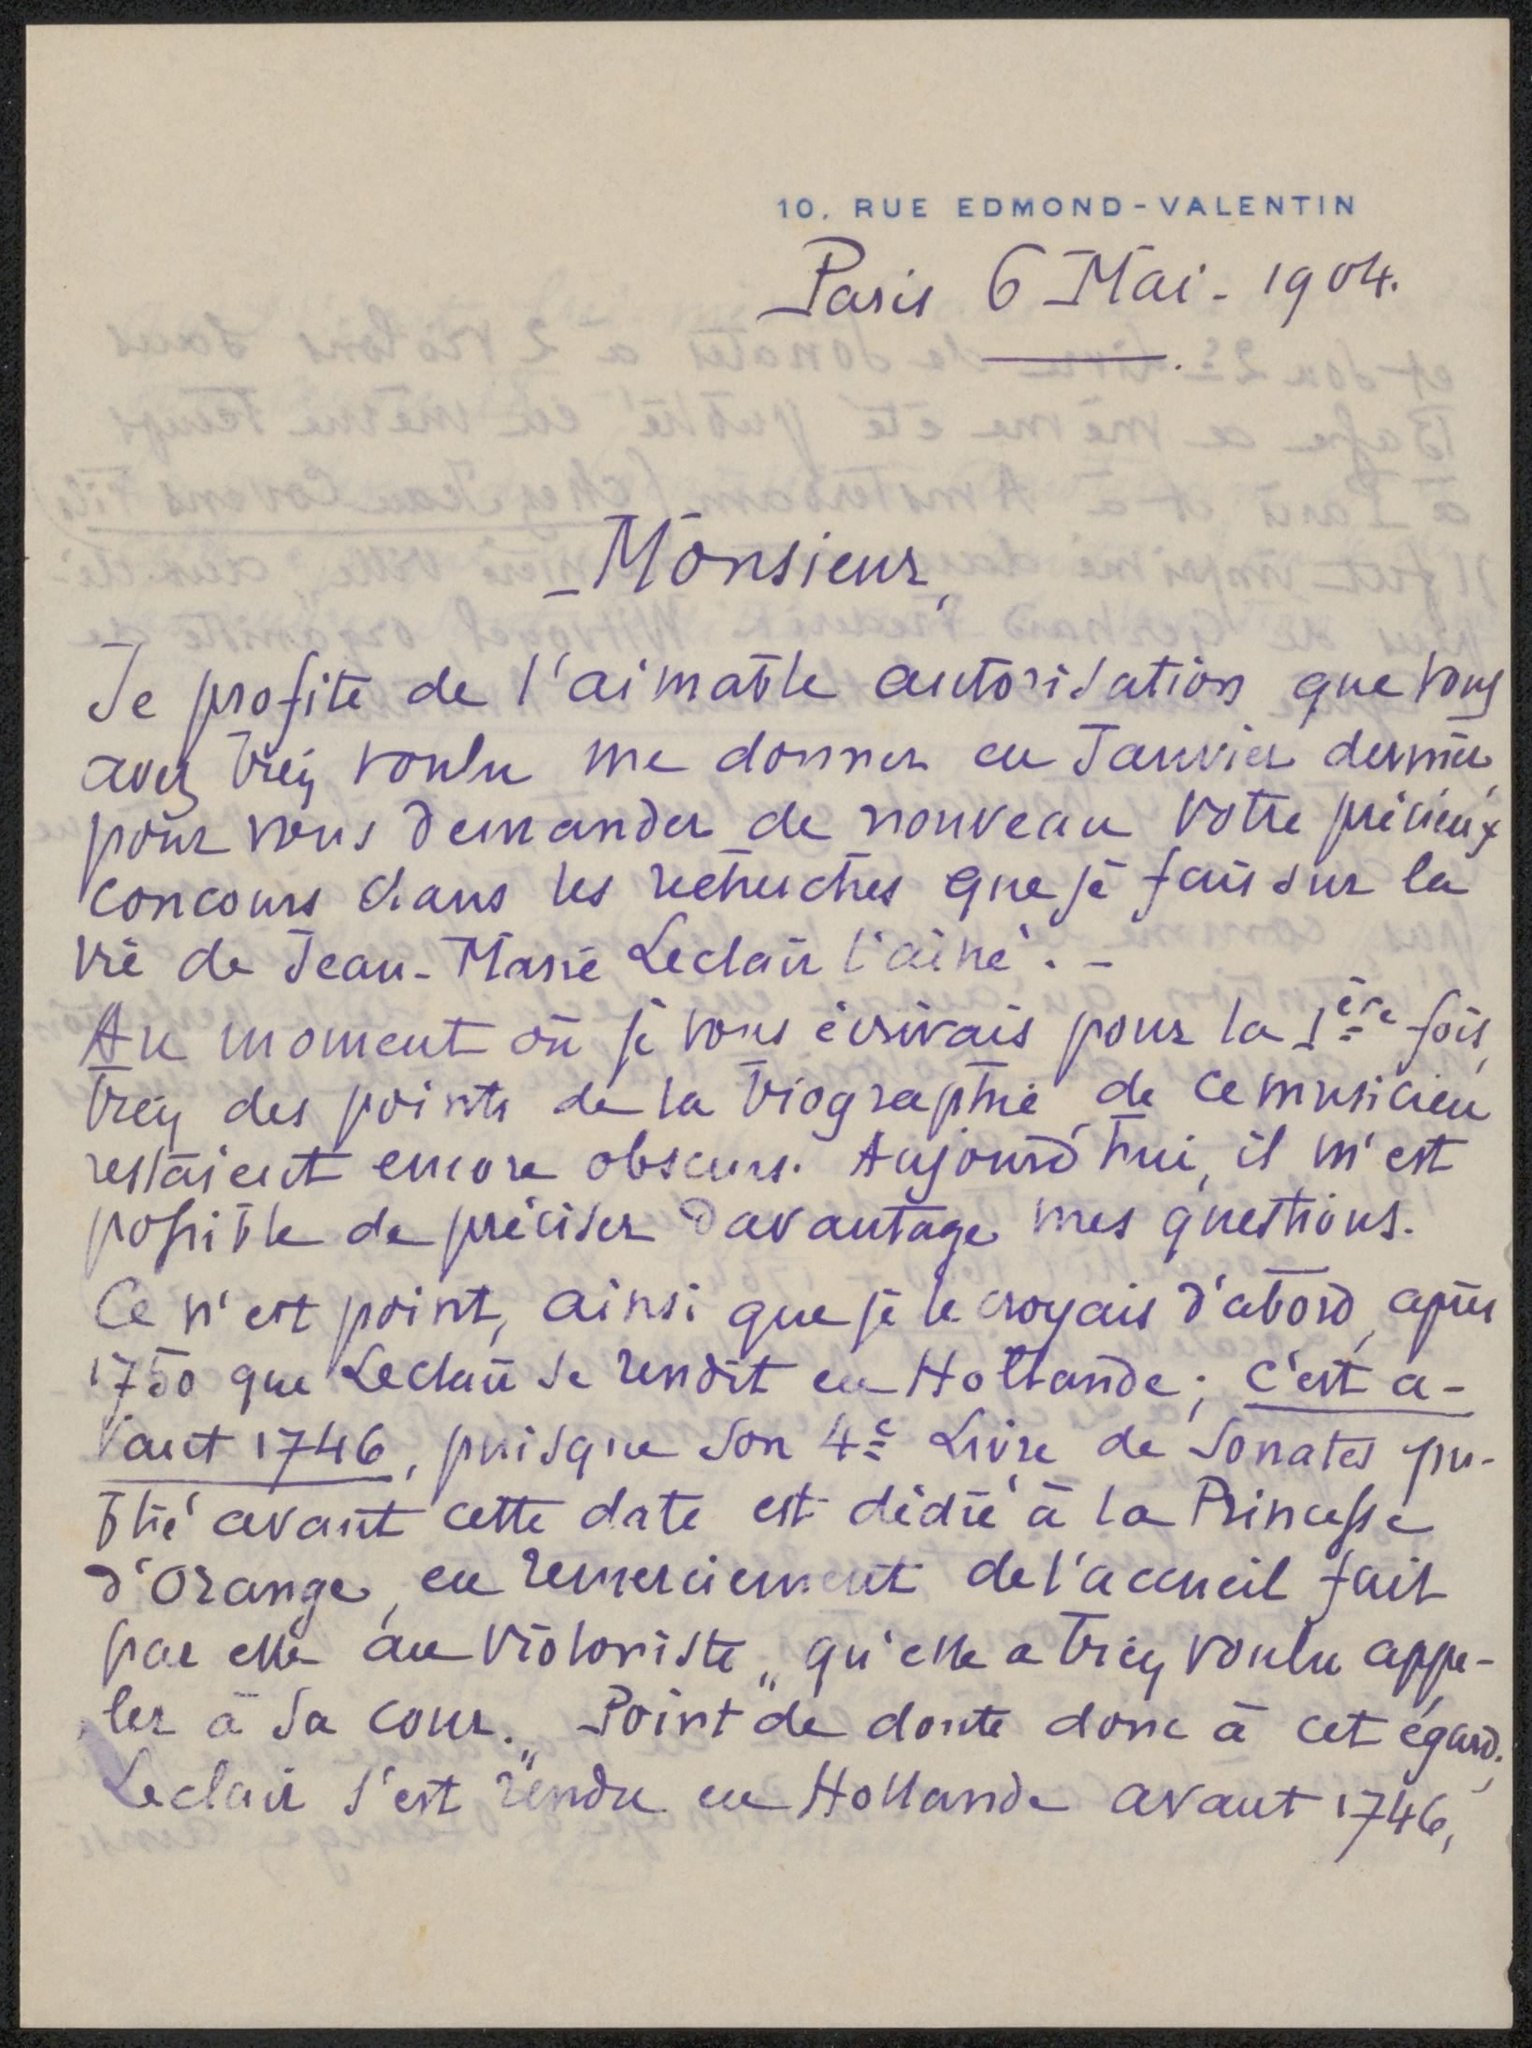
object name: letter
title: Brief aan Philip Zilcken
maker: lionel de la laurencie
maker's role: muziekwetenschapper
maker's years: 1861-1933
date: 1904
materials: ink, paper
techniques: pen, writing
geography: paris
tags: lyon, daniël françois scheurleer, the hague, draughtsman, philip zilcken, music, netherlands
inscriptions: collector's mark: ‘RPK’